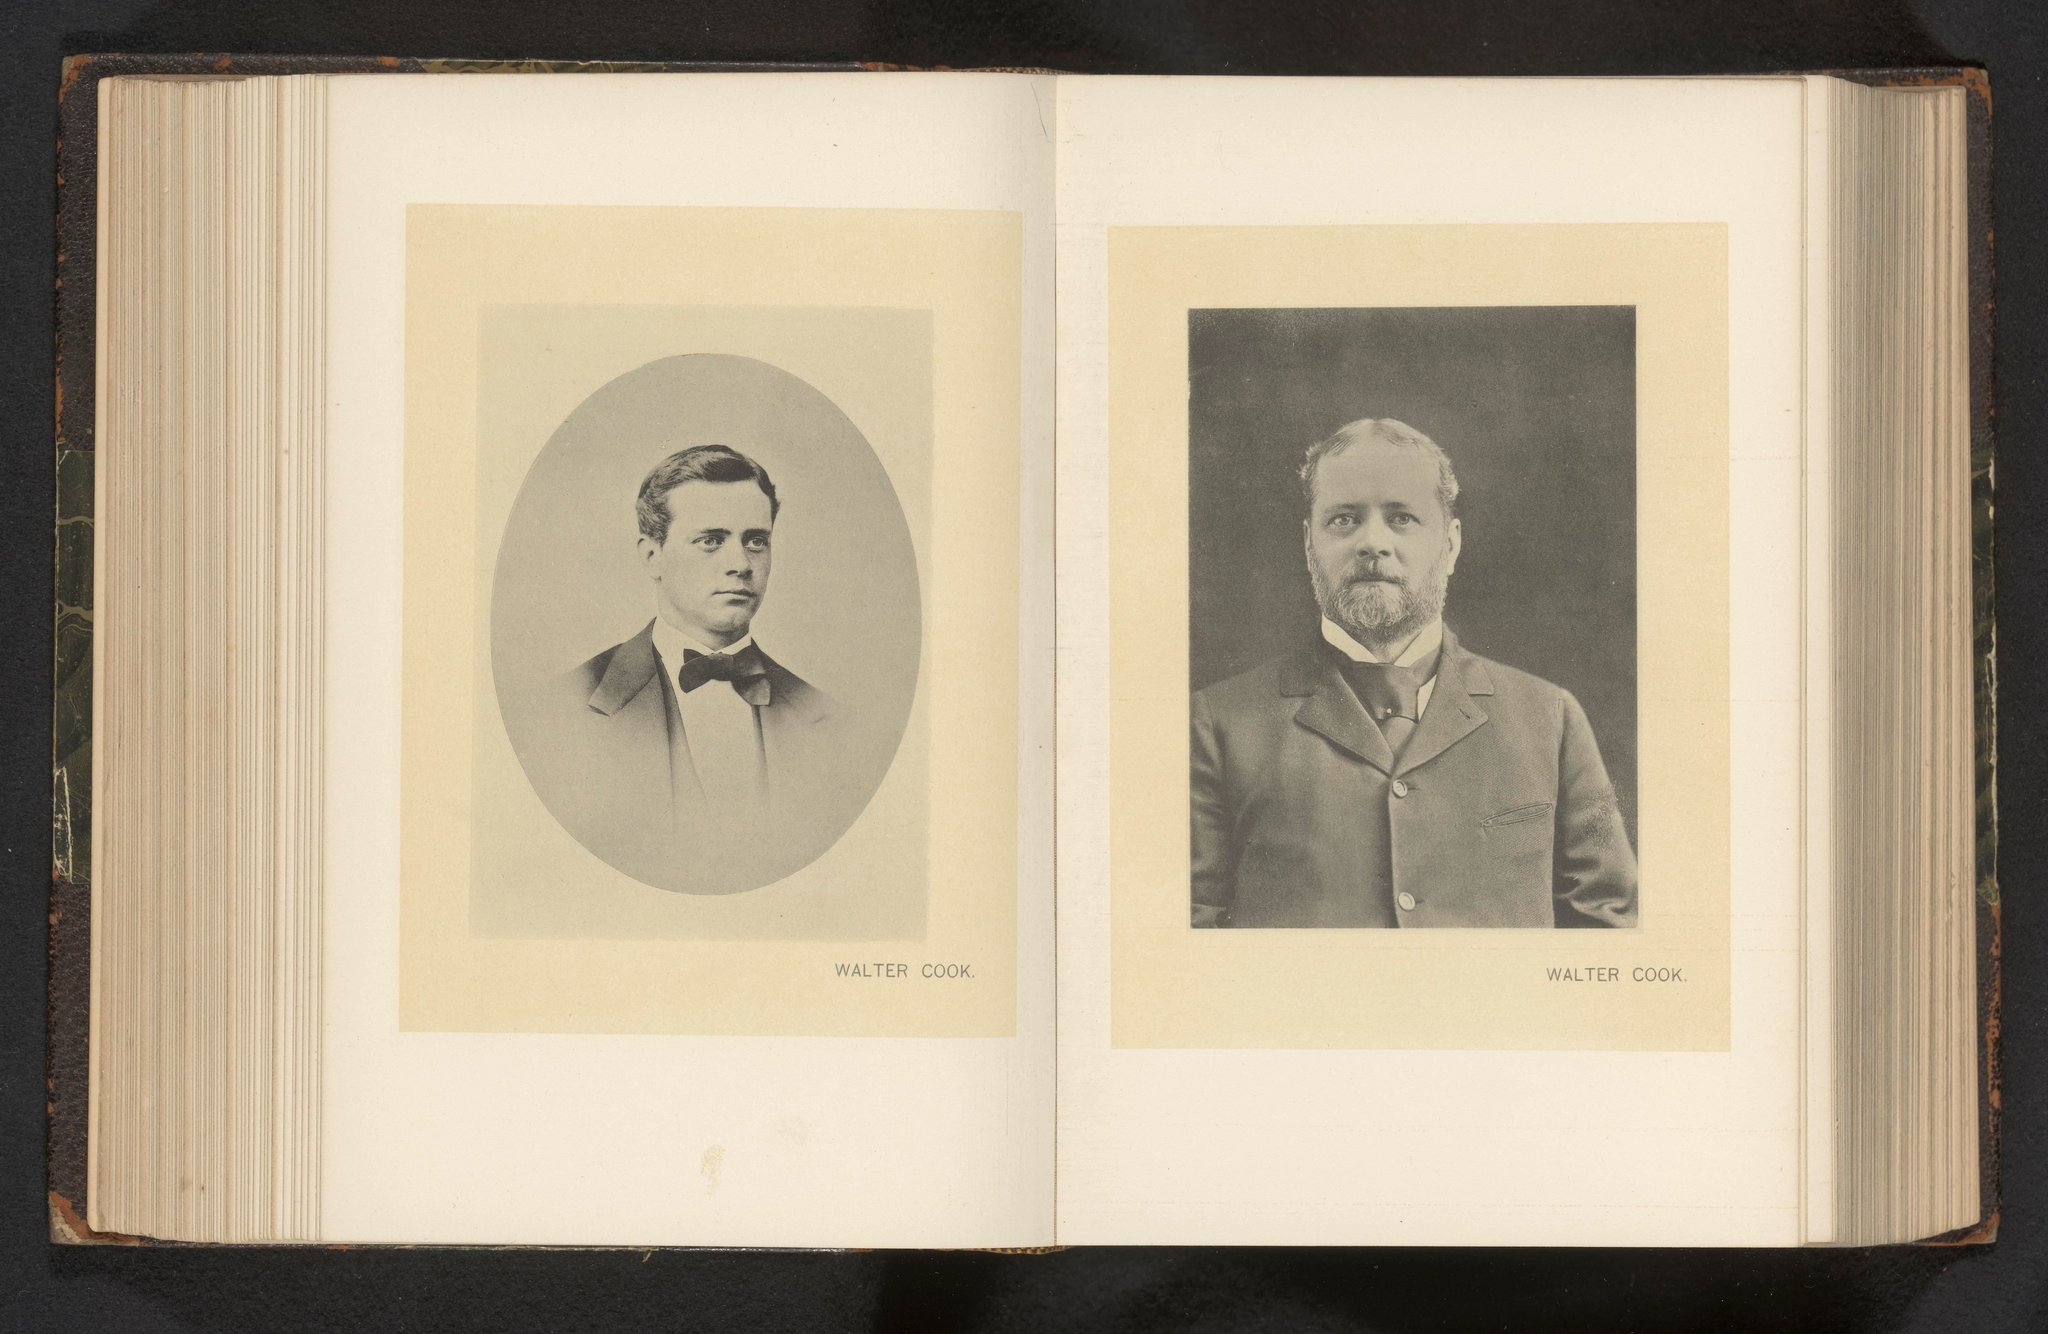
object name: photomechanical print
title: Walter Cook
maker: Anonymous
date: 1889-1894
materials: paper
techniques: photoaquatint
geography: boston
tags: adult man